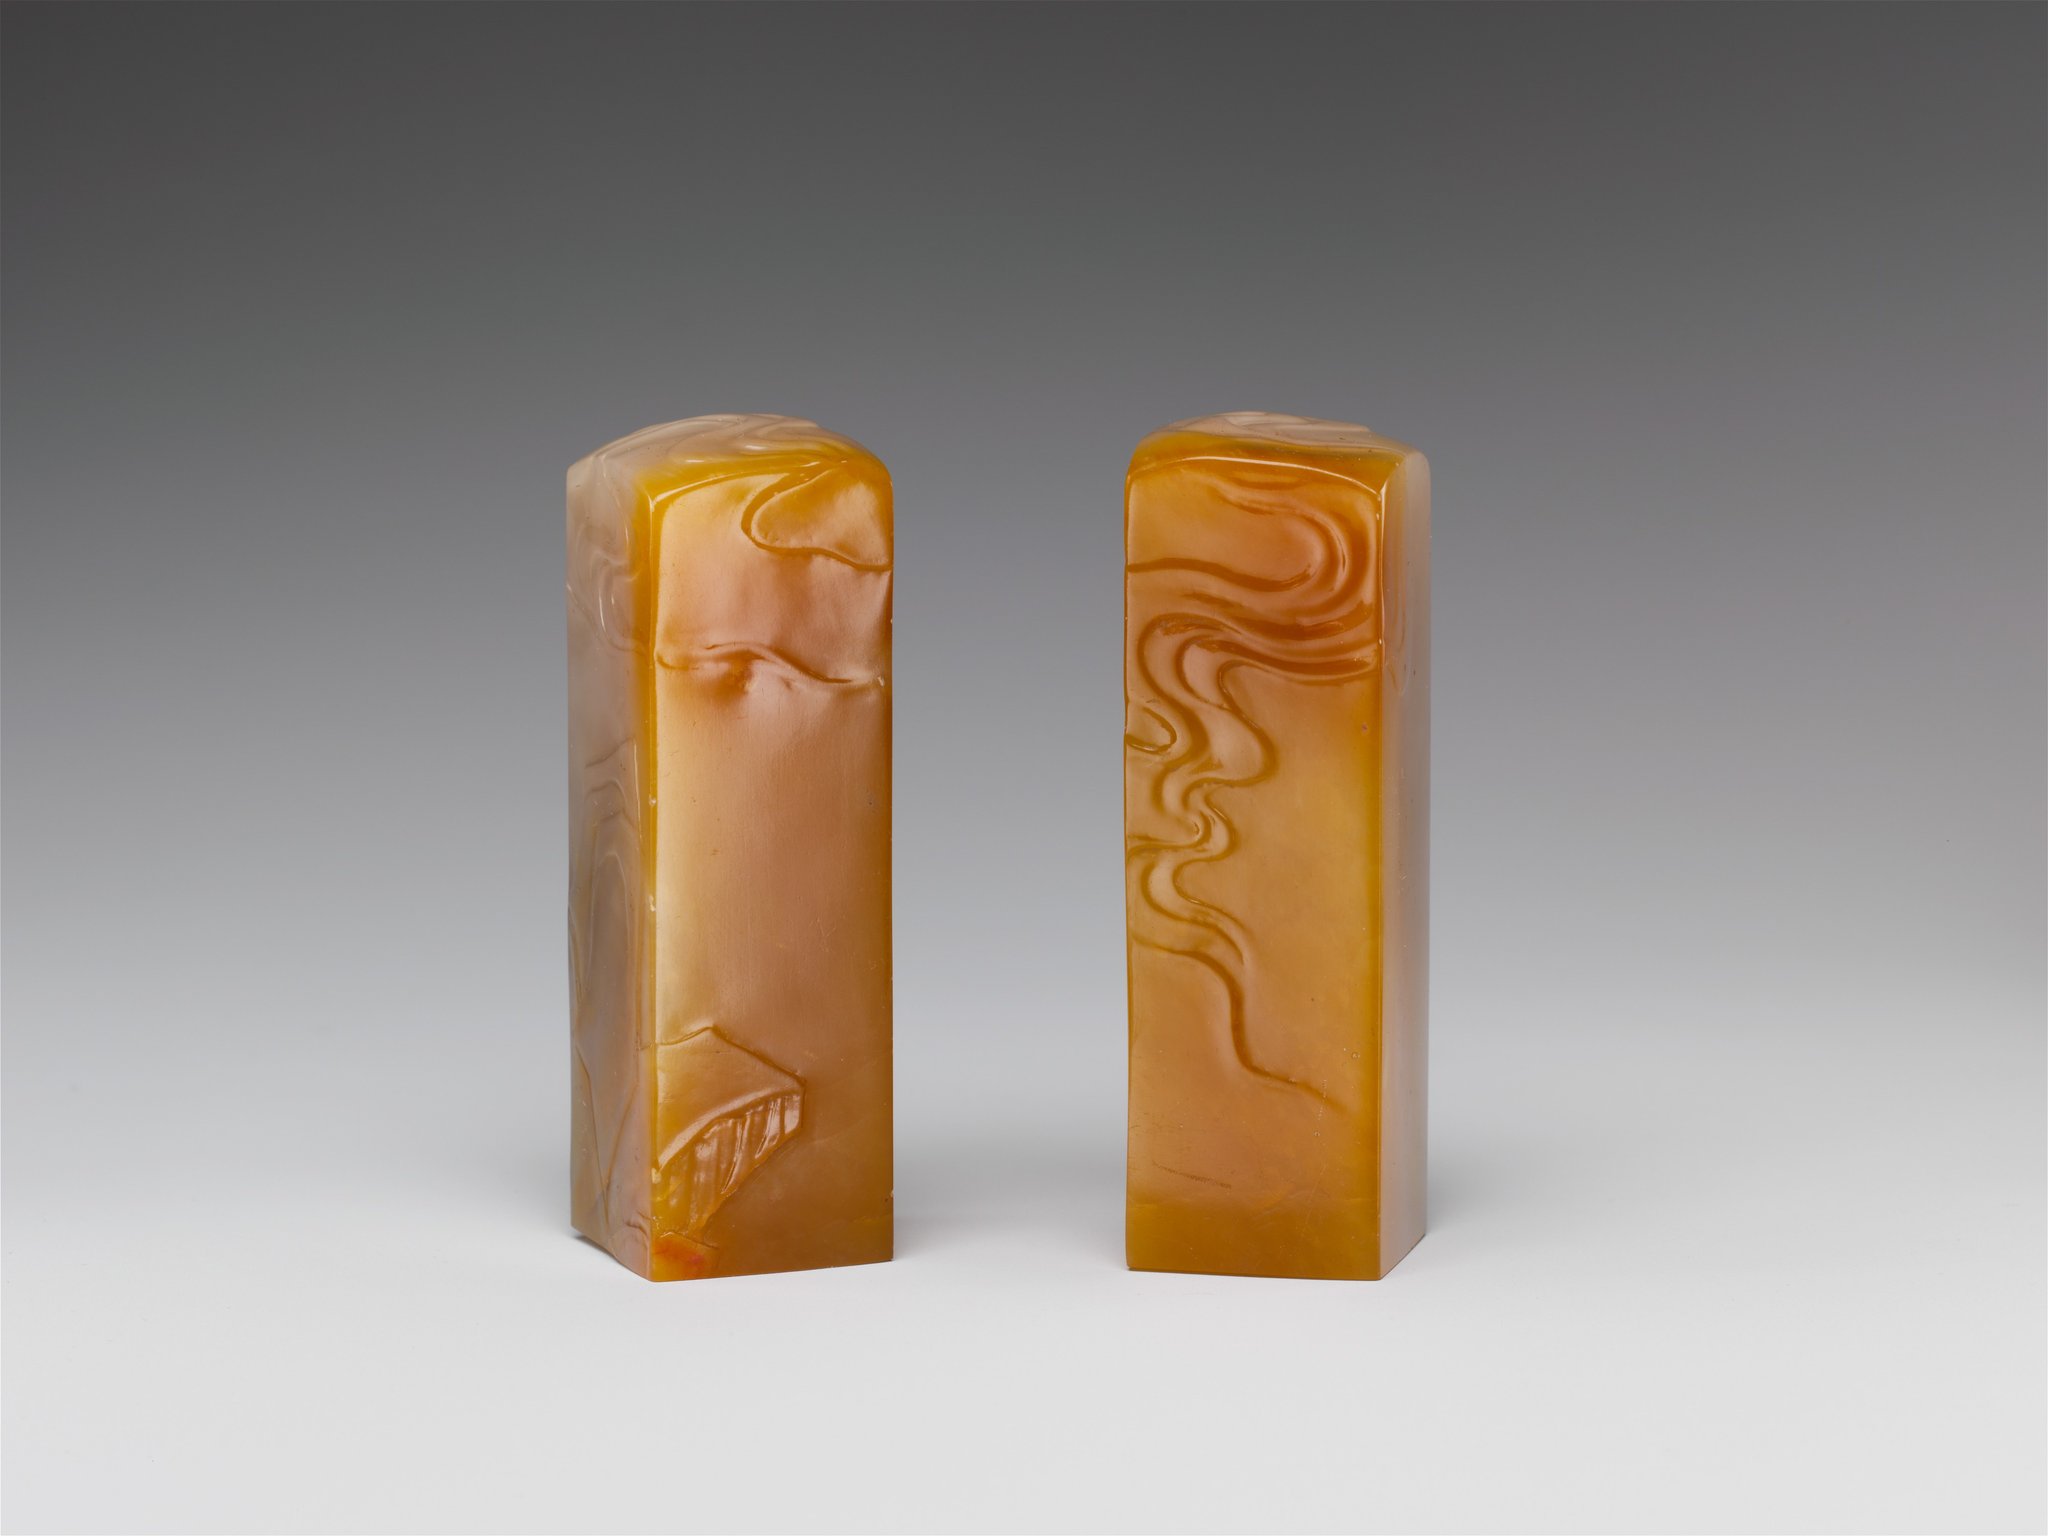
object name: seal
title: Pair of Square Seals with Cloud and Rock Pattern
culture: chinese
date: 1901-2000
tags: clouds